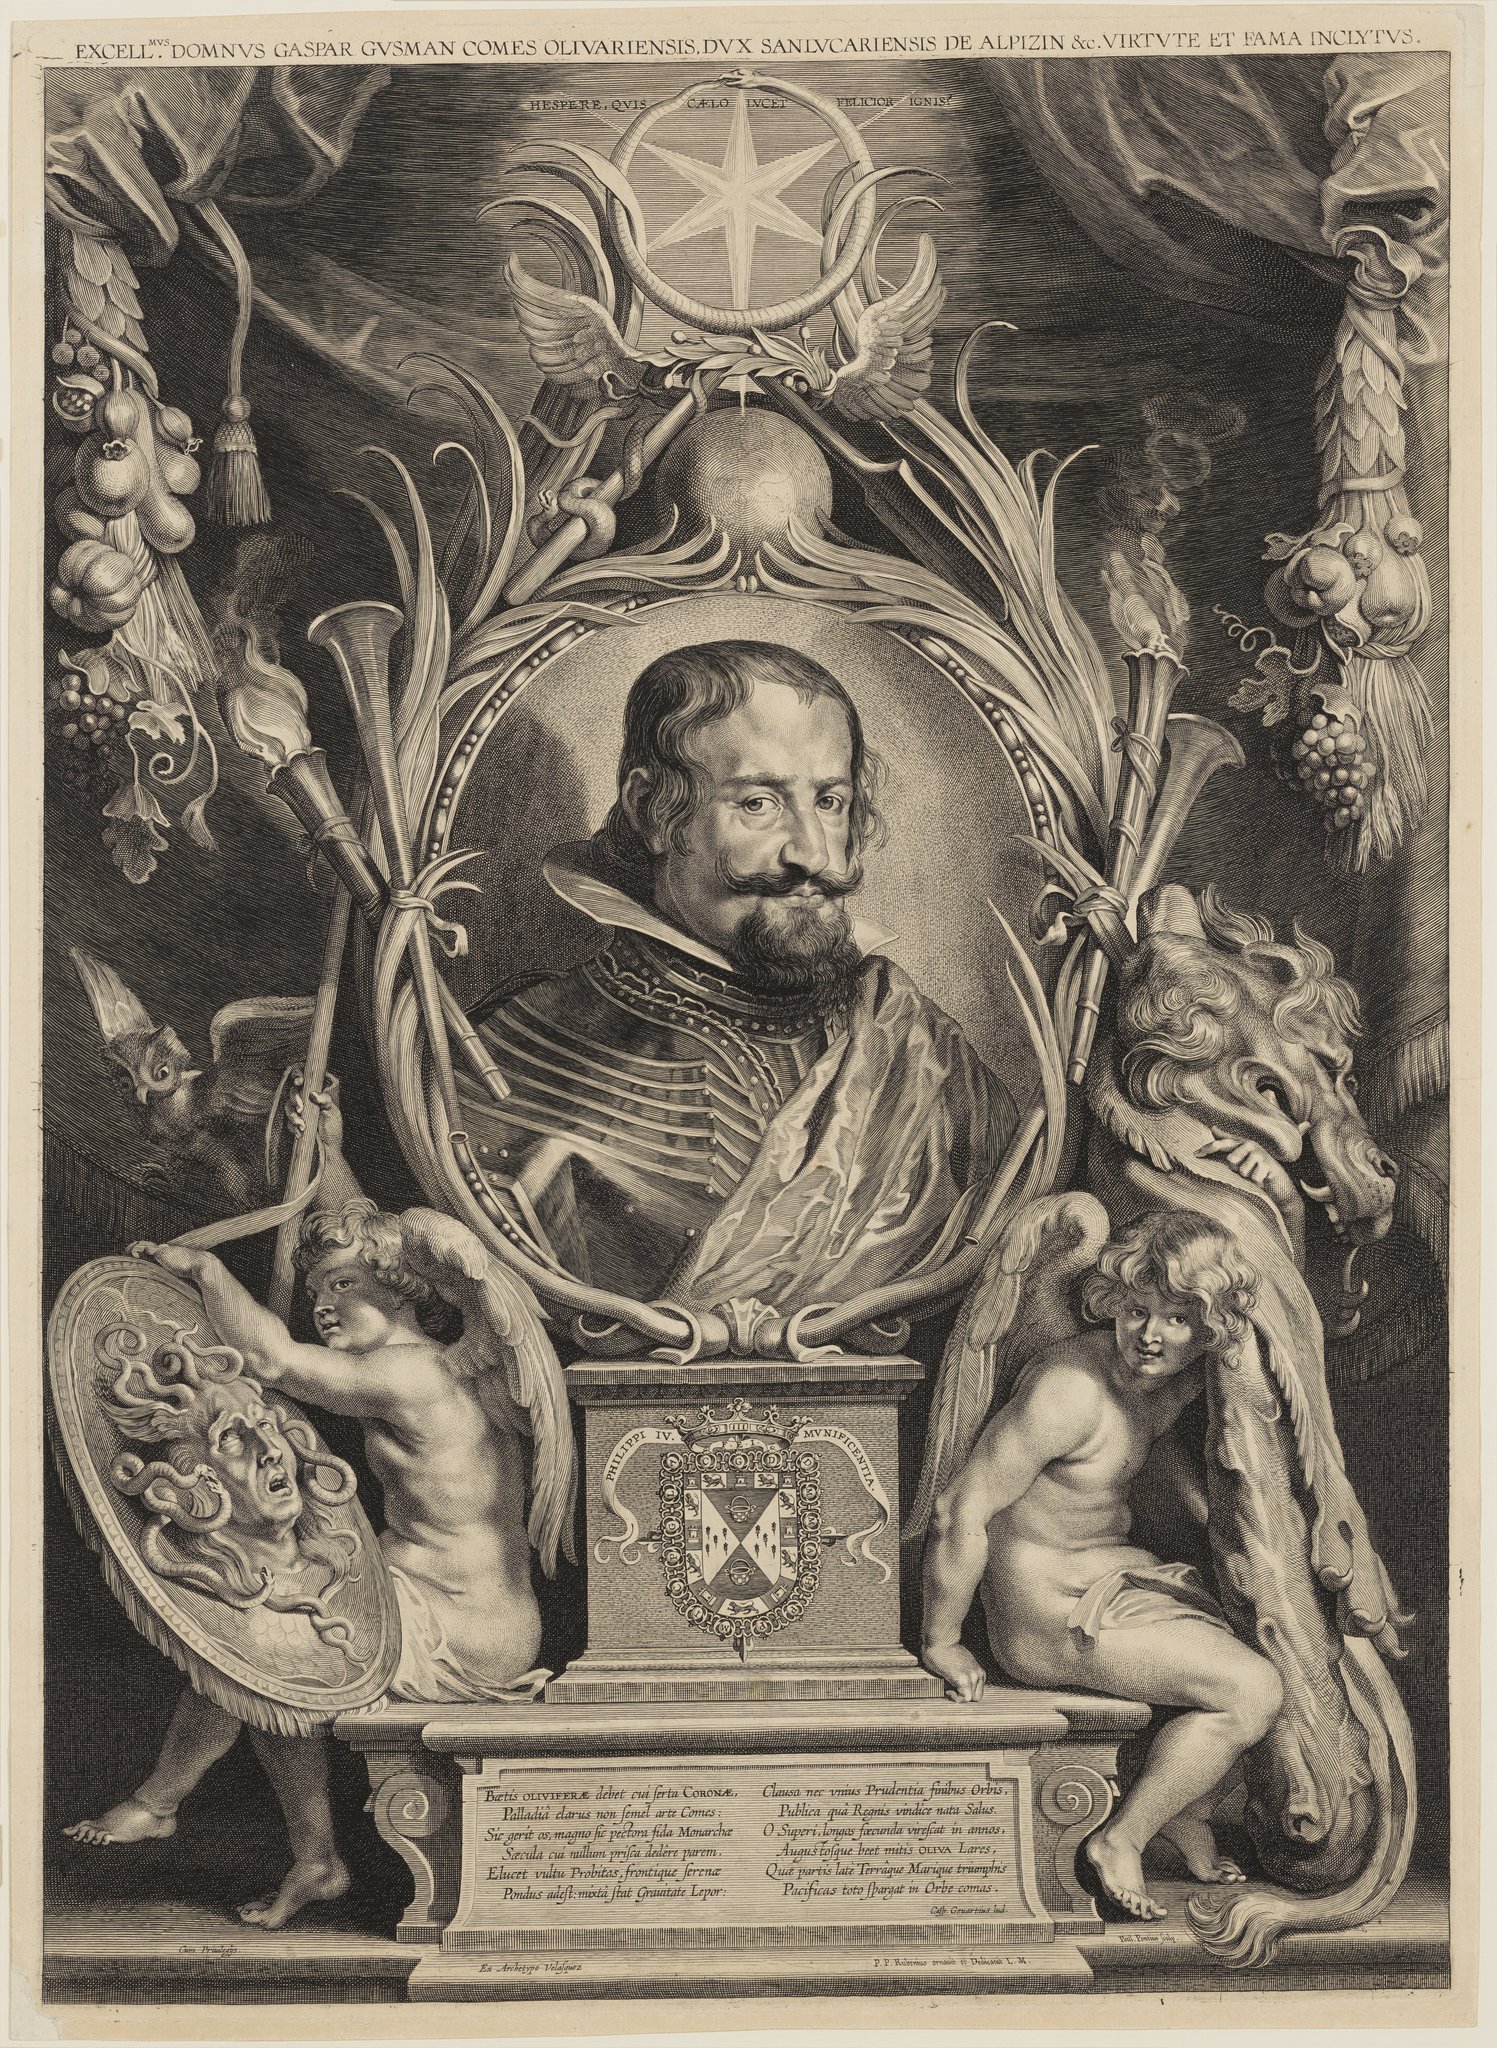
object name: print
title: Don Gaspar de Guzmán, Count-Duke of Olivares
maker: paulus pontius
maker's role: artist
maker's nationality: flemish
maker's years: 1603-1658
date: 1626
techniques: engraving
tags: men,portraits,coat of arms